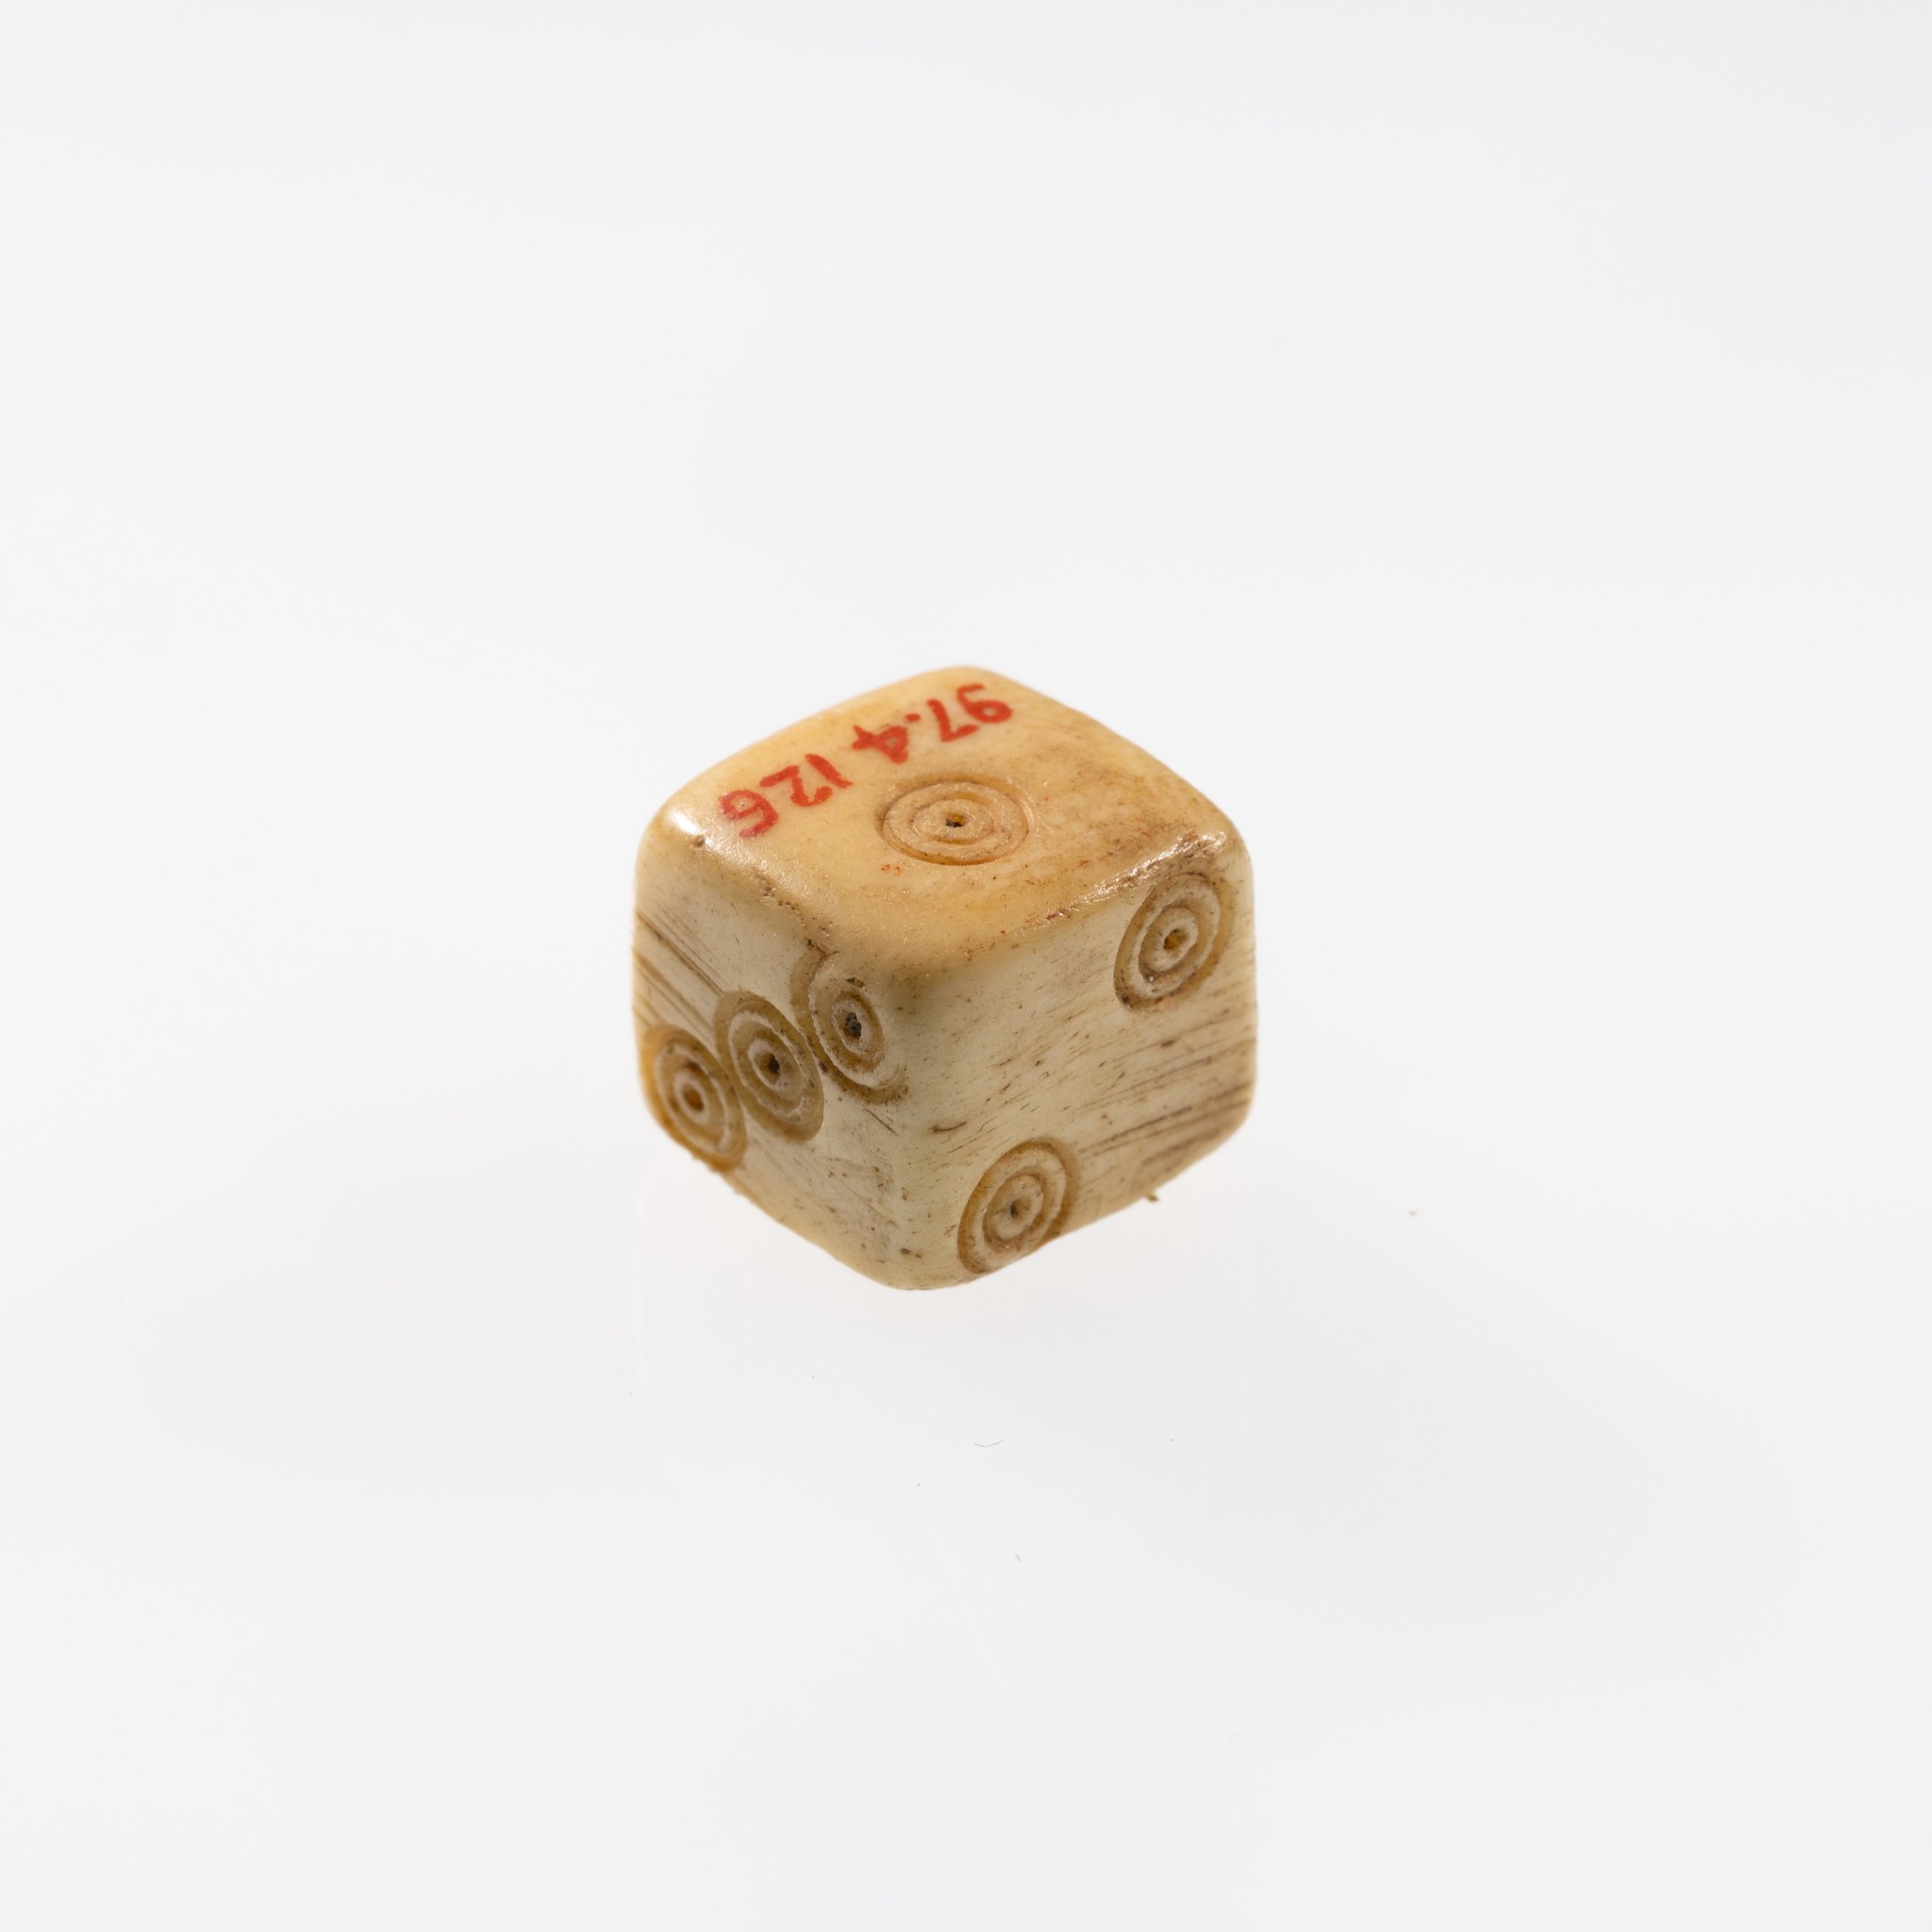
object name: dice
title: Die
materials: ivory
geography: egypt